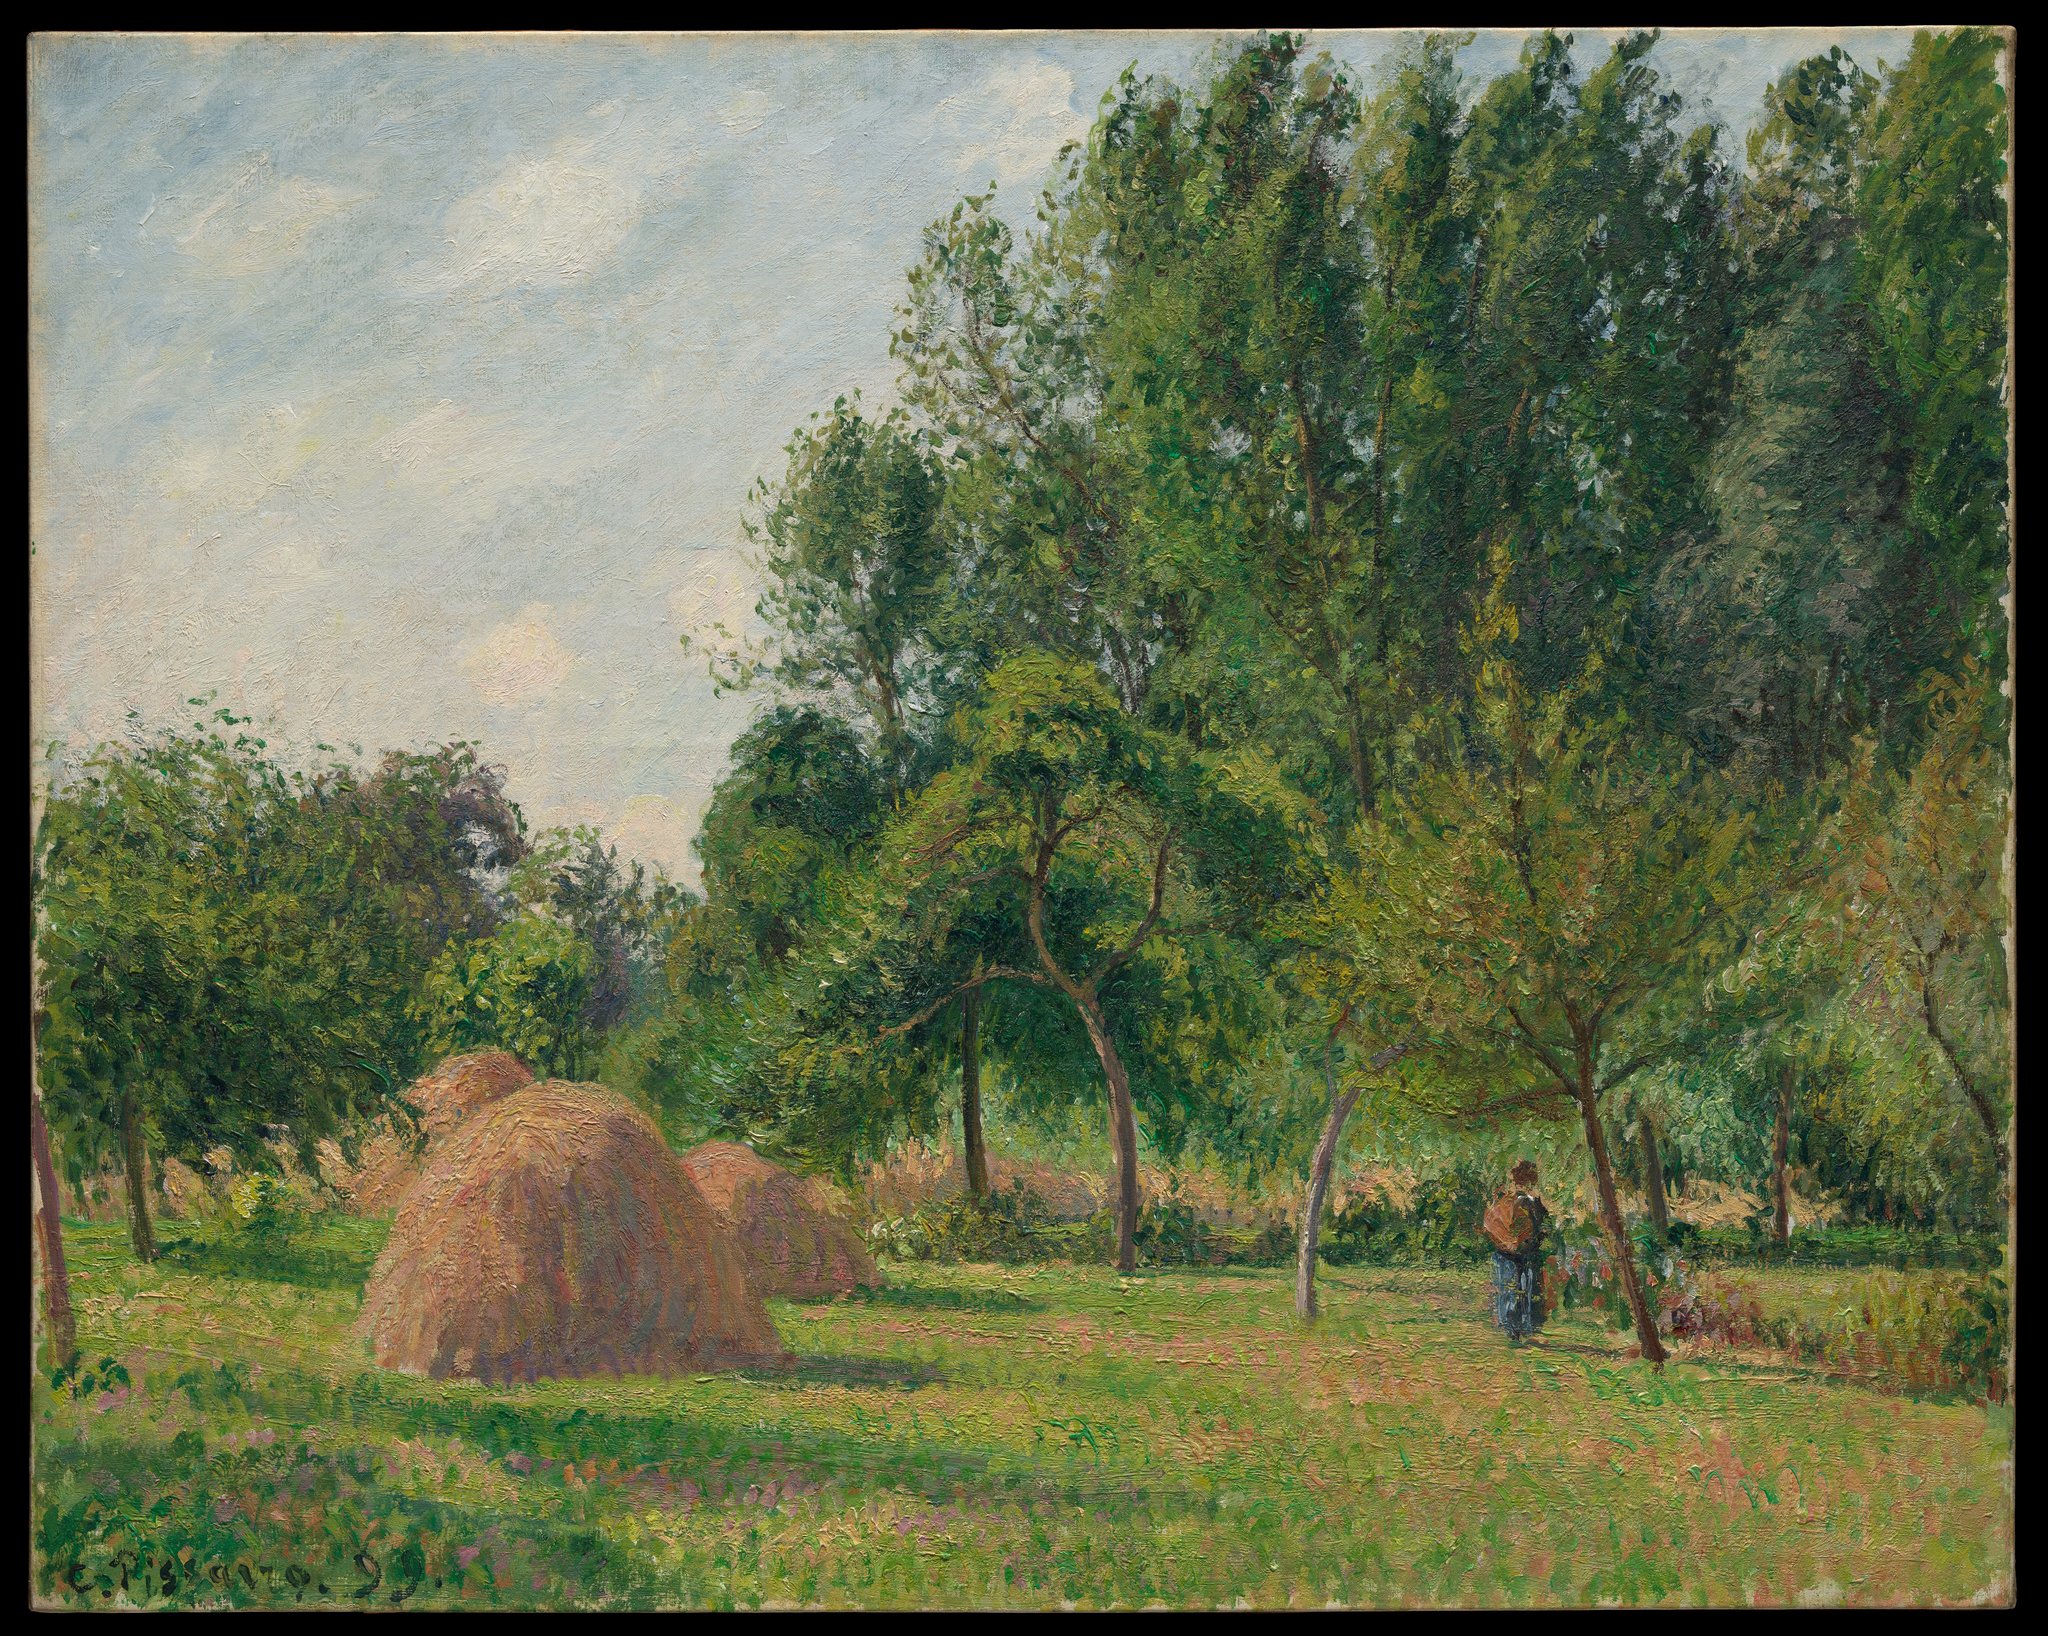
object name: painting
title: Haystacks, Morning, Eragny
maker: camille pissarro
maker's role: artist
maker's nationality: french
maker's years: 1830-1903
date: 1899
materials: canvas, oil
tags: landscapes,morning,haystacks